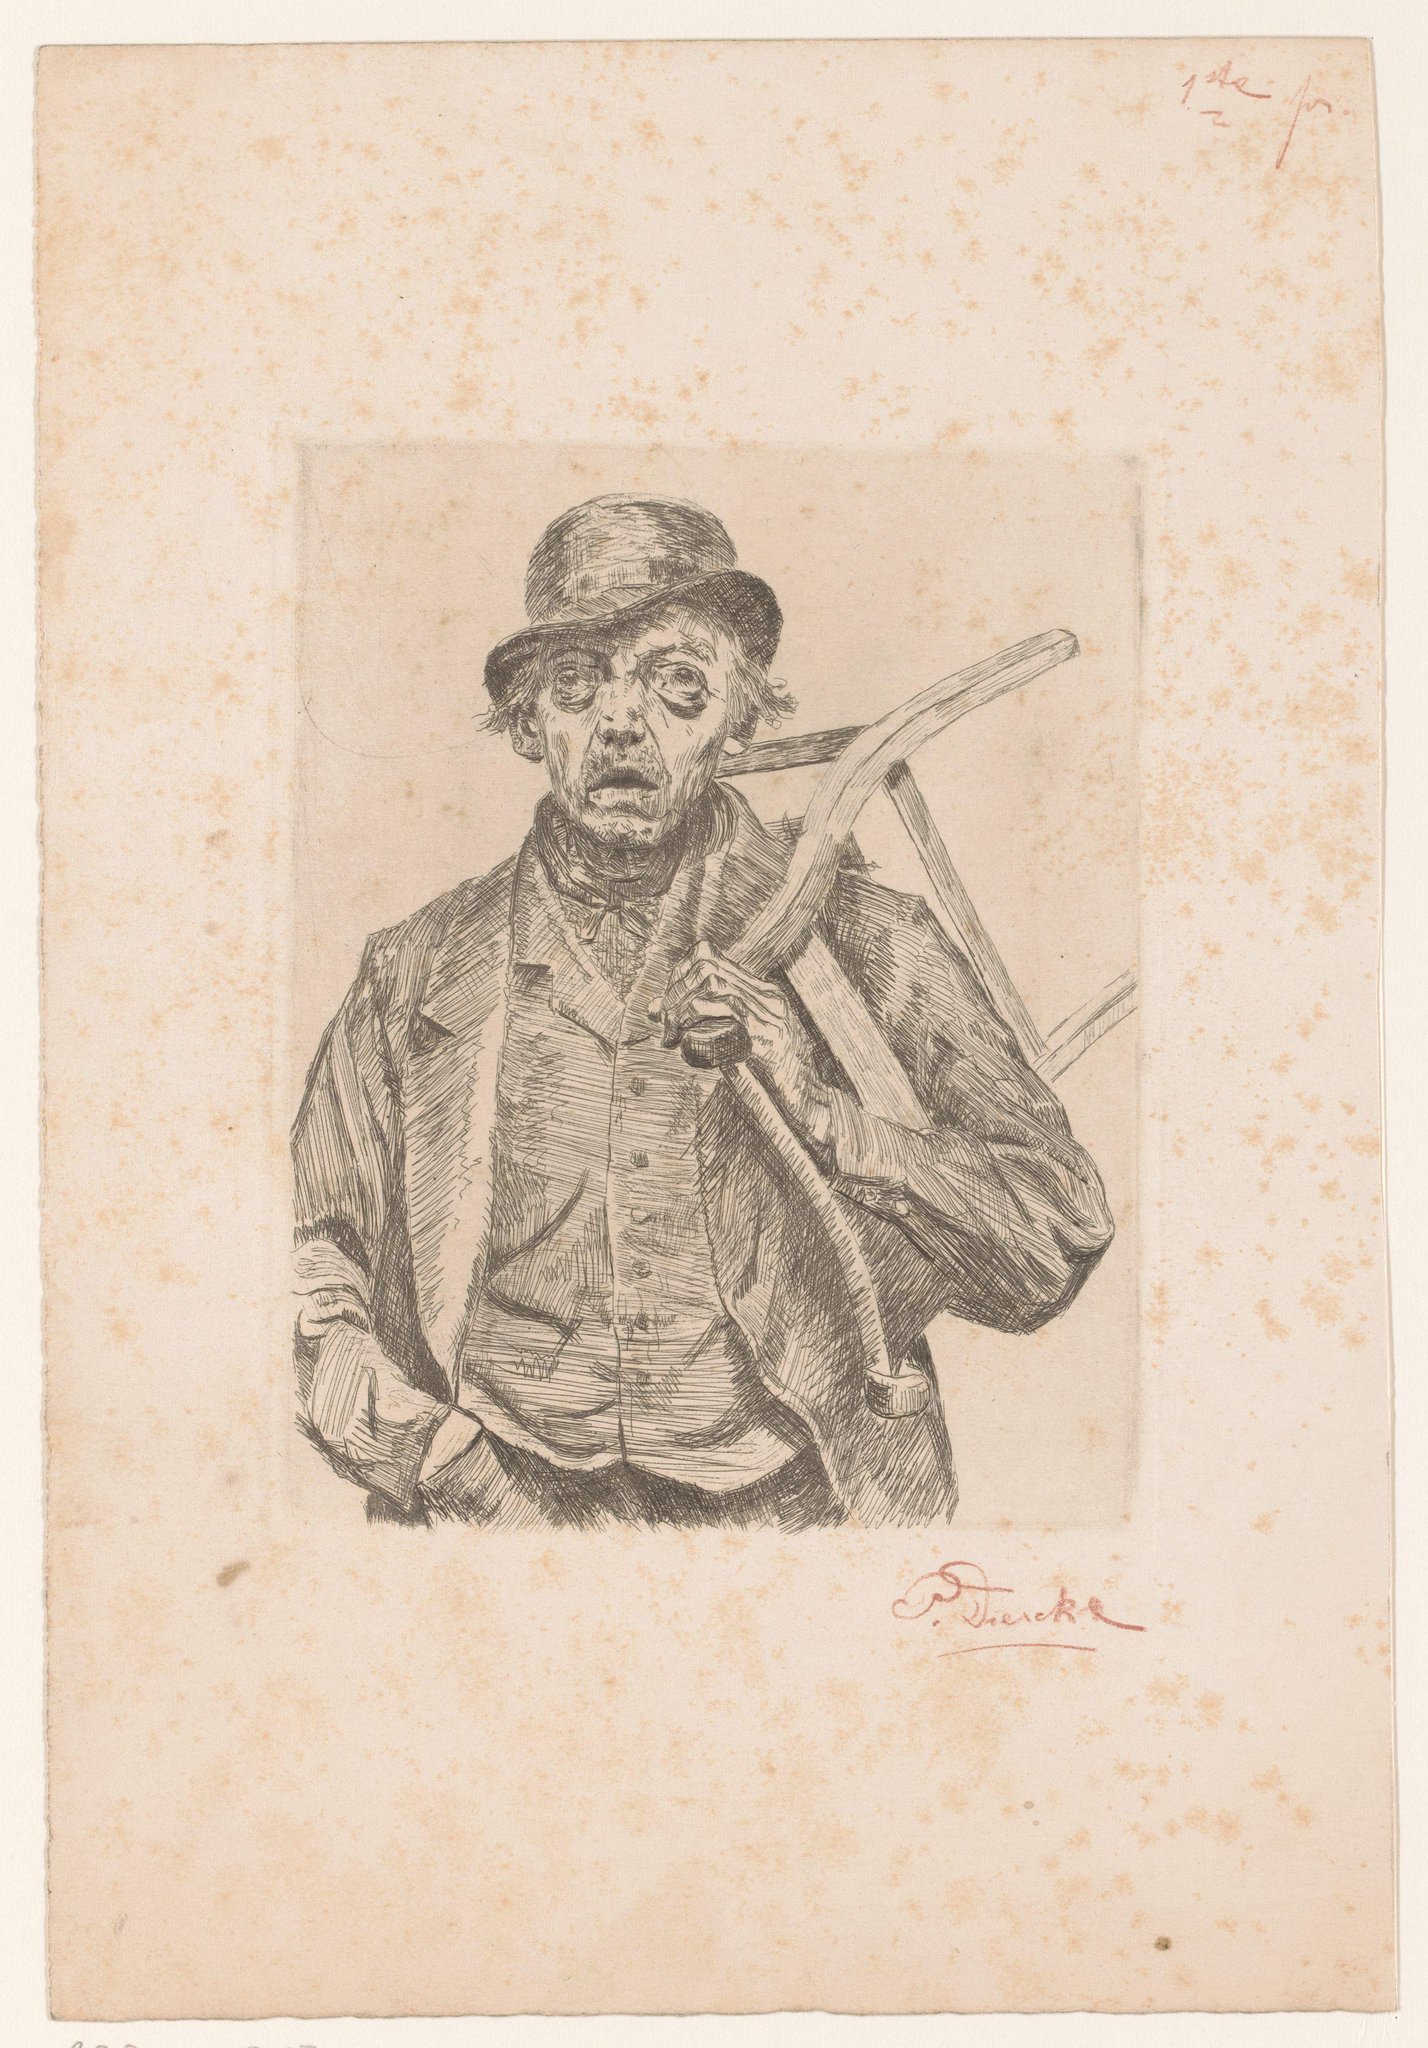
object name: print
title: Oudere man met hoed en een stoel over zijn schouder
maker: pierre jacques dierckx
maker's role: painter, print maker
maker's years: 1855-1947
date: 1865-1909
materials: paper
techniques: etching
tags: old man, chair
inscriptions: inscription: ‘1 ste pr’, collector's mark: Lugt 2228